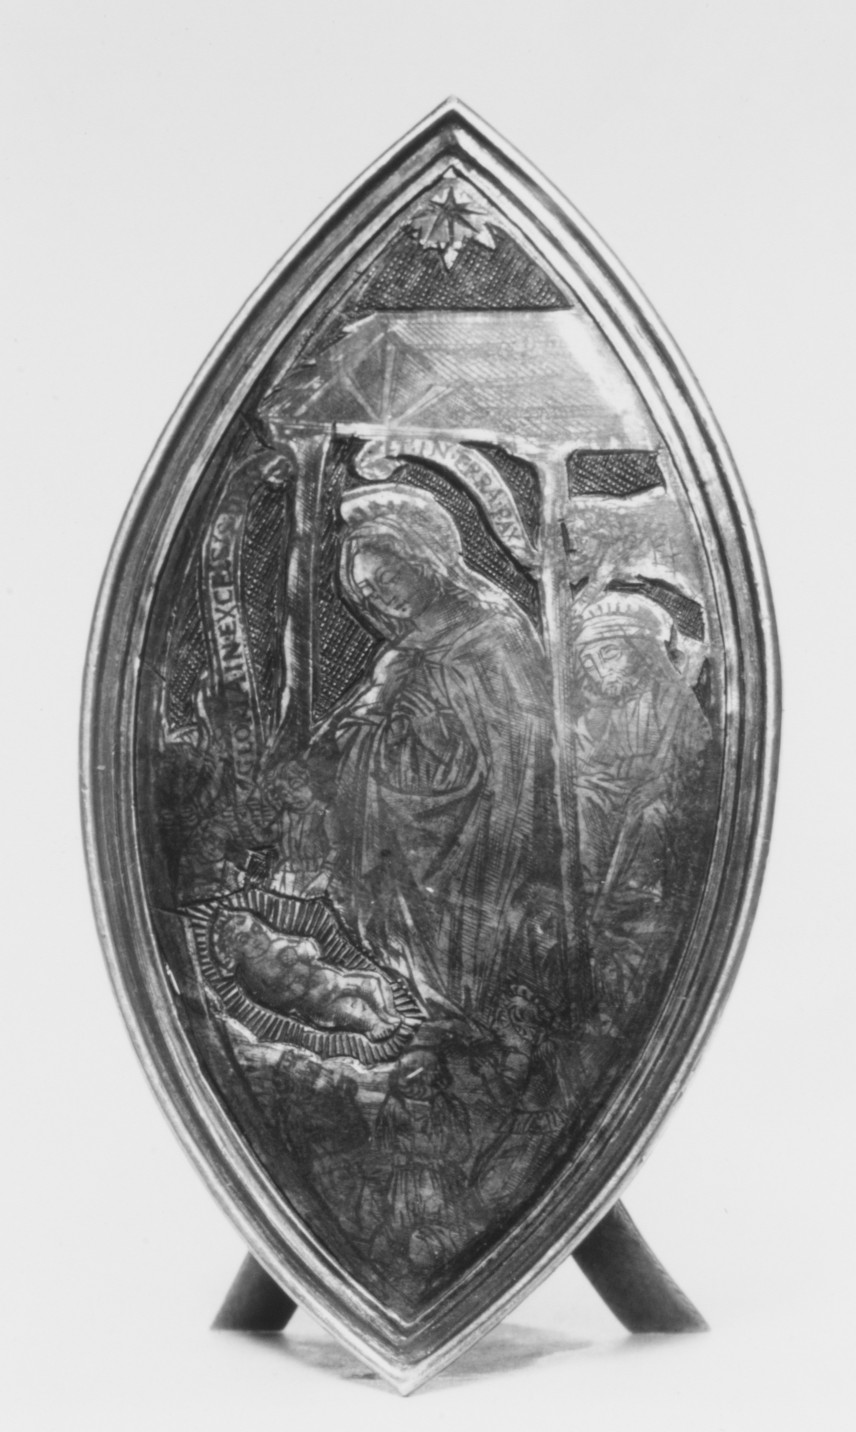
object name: plaque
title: The Nativity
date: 1451-1500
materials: silver gilt, niello, silver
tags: virgin mary,jesus,nativity